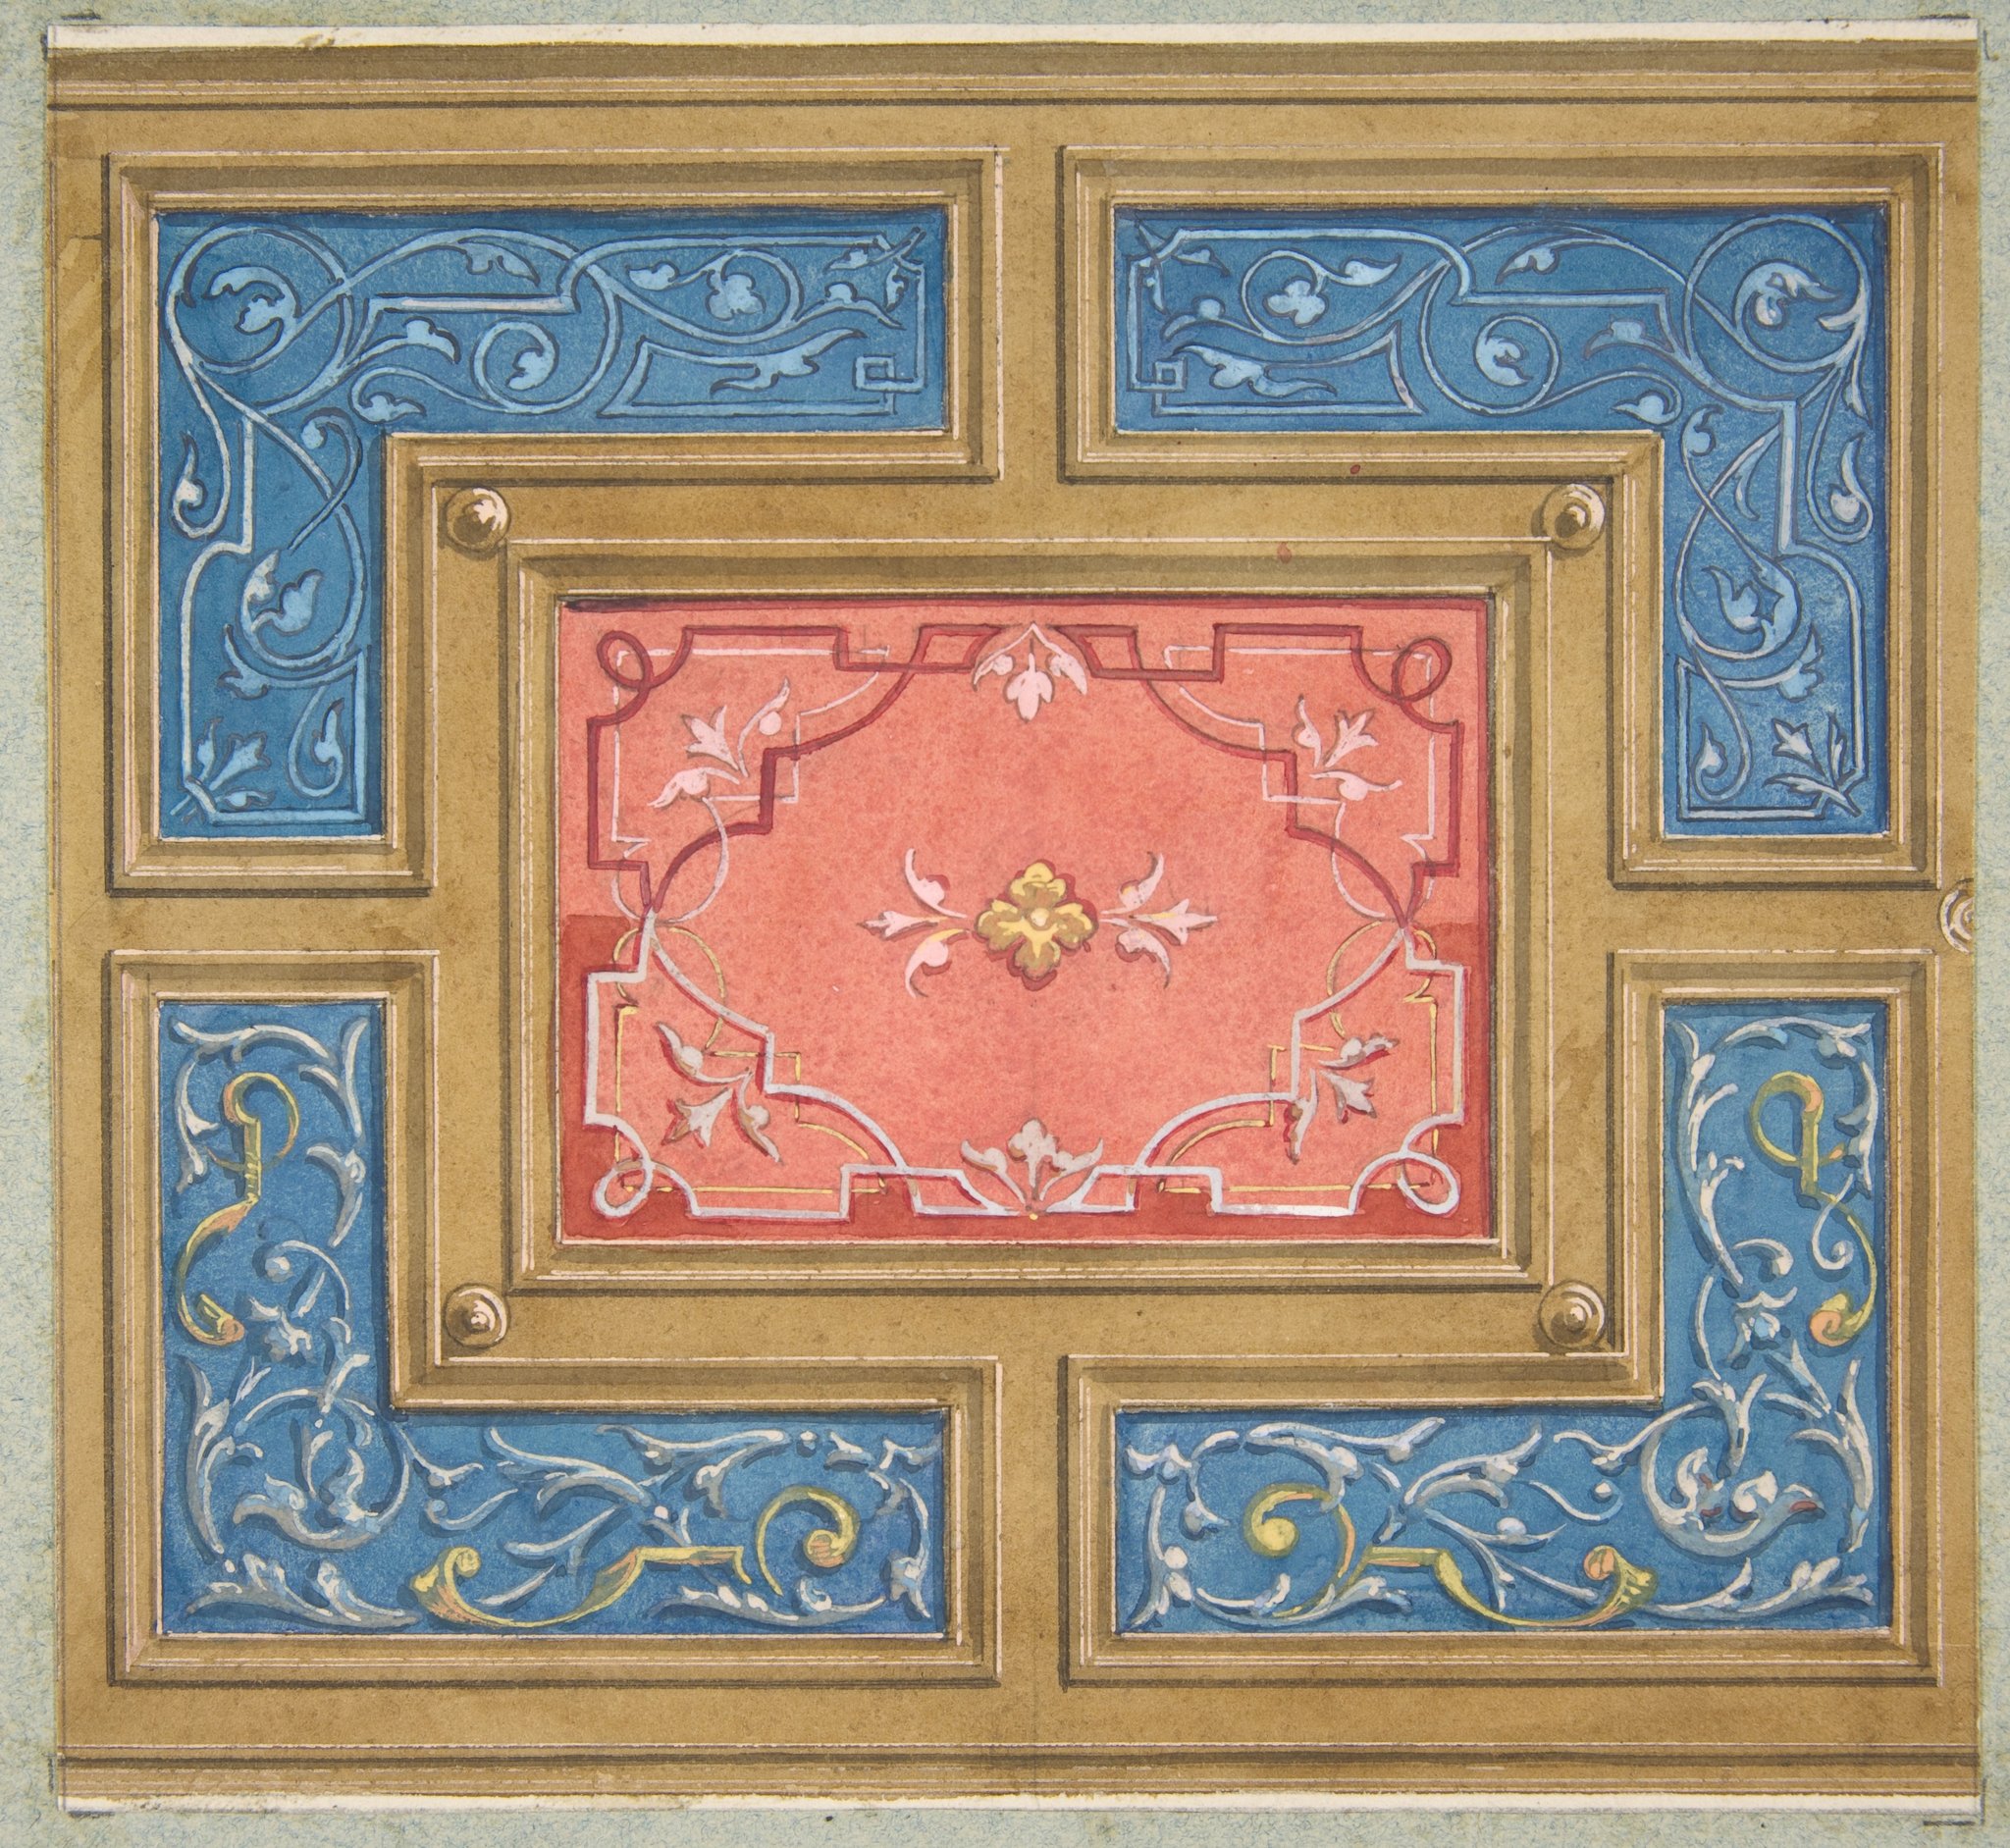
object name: drawing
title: Design for a coffered ceiling with painted panels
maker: jules-edmond-charles lachaise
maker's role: artist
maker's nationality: french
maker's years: 1897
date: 1840-1897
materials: gouache, ink, watercolor, paper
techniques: inlay, pen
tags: ceilings